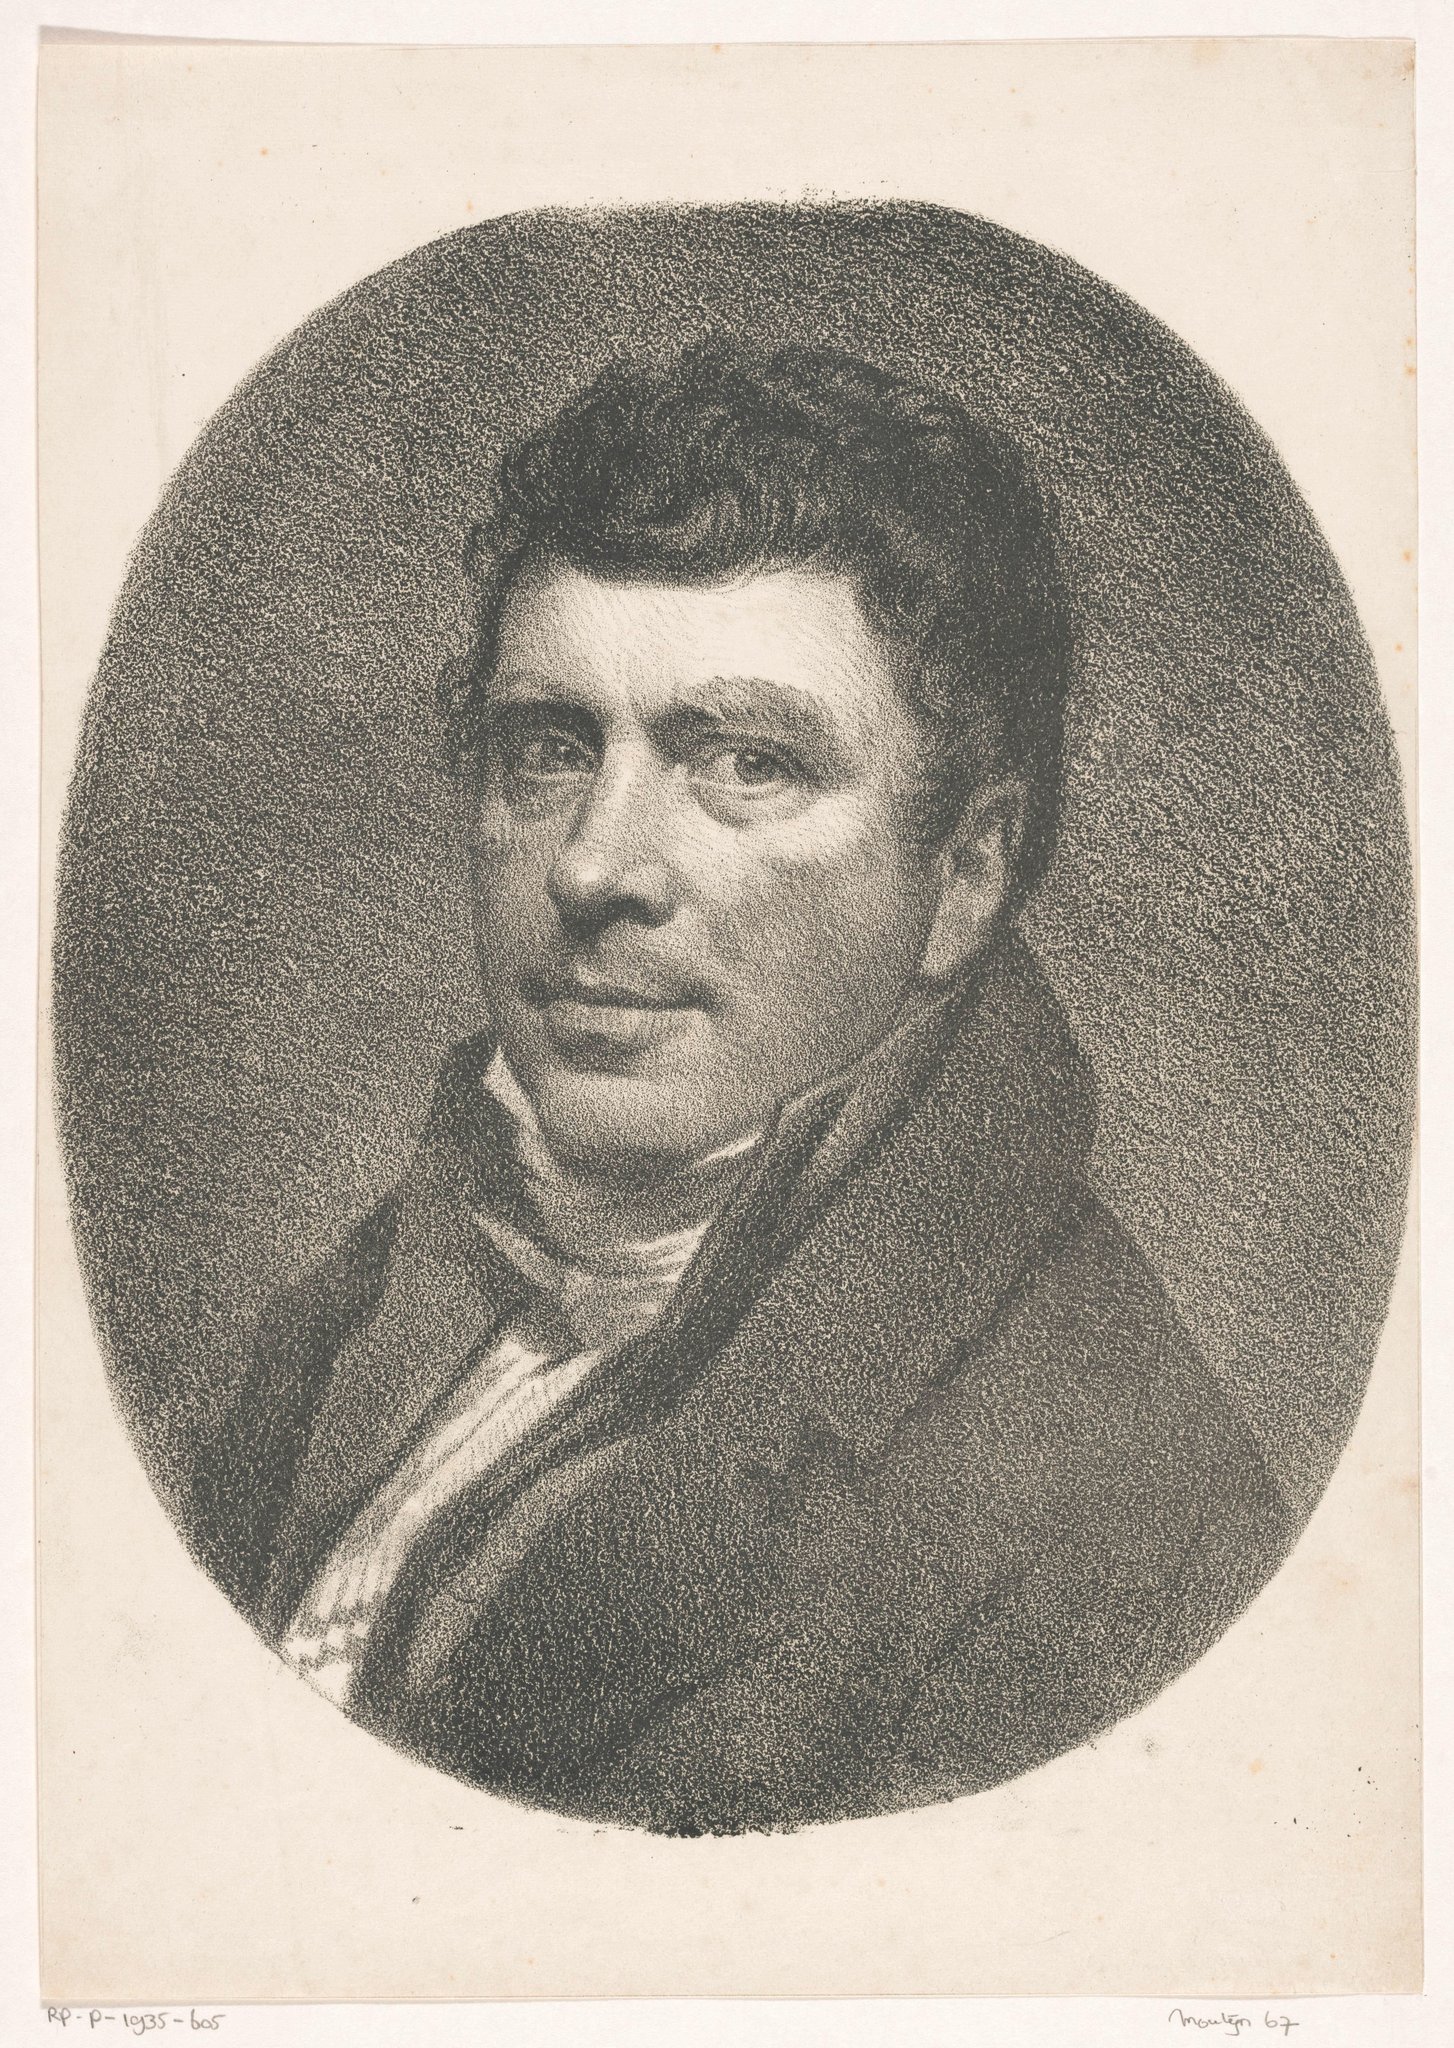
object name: print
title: Zelfportret van Willem Bartel van der Kooi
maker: willem bartel van der kooi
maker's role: draughtsman, painter, print maker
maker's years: 1768-1836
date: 1819-1836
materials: paper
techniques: lithograph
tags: painter, print maker, draughtsman, willem bartel van der kooi, portrait, self-portrait of painter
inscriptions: collector's mark: Lugt 2228, inscription: ‘Portret van den vrieschen schilder Van der Kooi door hemzelven gelithographeerd’, collector's mark: Lugt 2760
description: Naar een pasteltekening in bruikleen van het Gemeentearchief Leeuwarden aan het Fries Museum Leeuwarden.